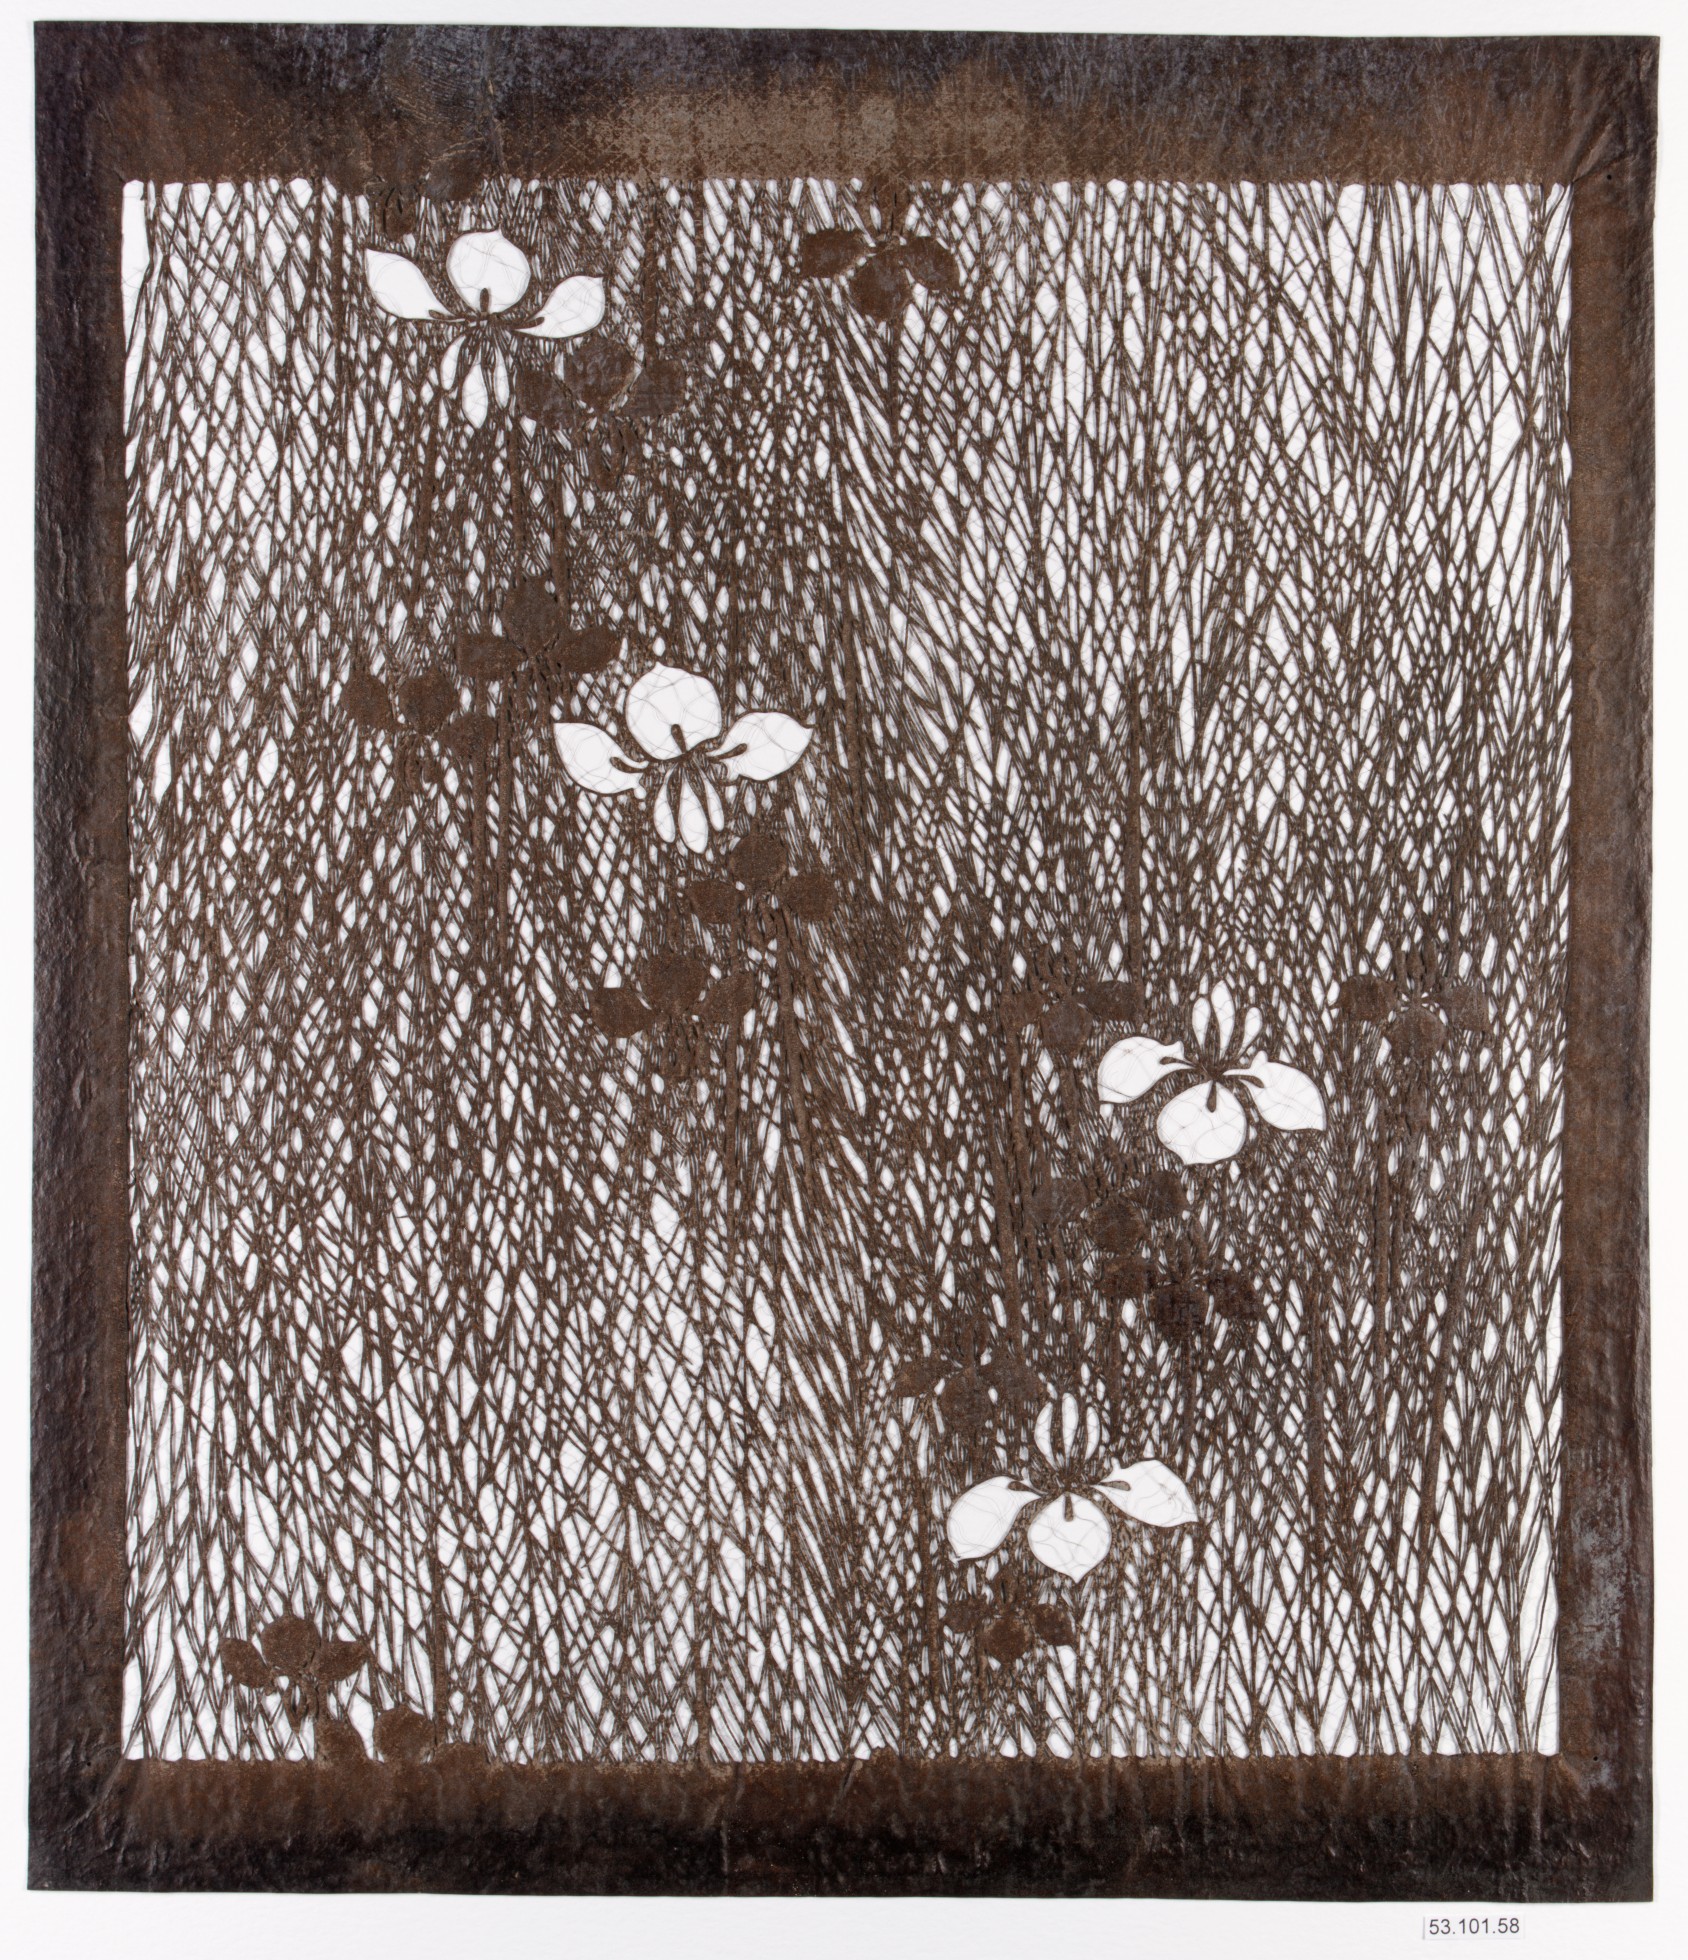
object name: stencil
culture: japanese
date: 1615-1868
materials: paper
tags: flowers